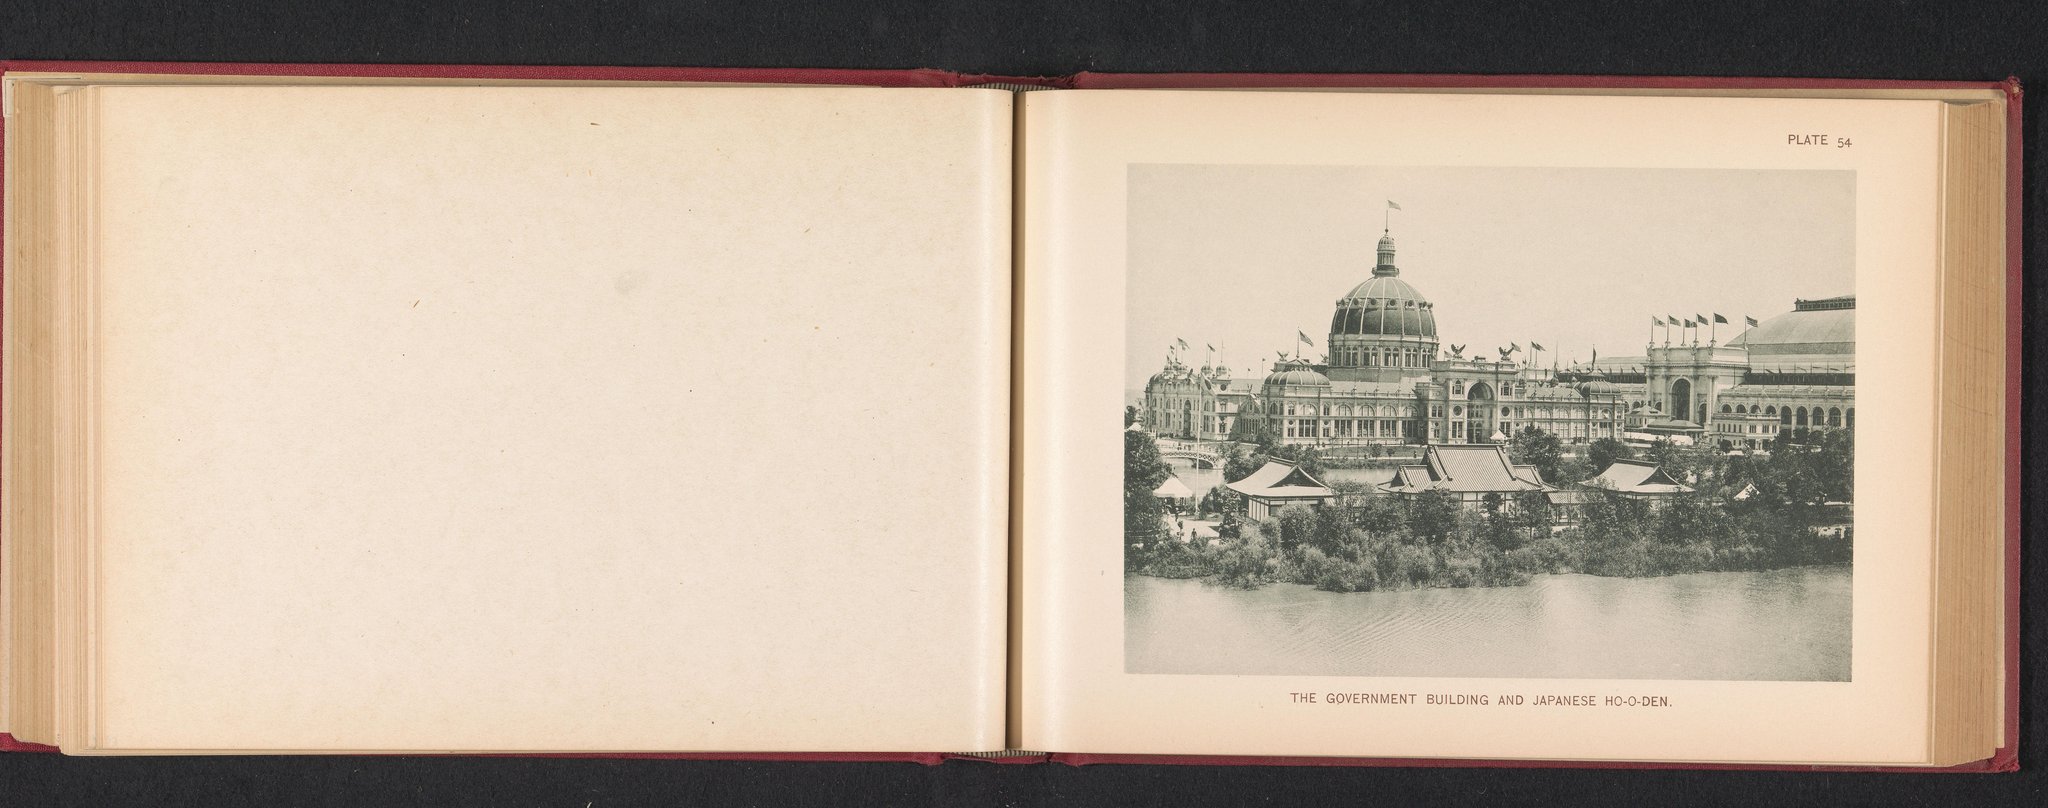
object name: page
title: The Government Building and Japanese Ho-o-den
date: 1893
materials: paper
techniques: photograph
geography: chicago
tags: world fair, world exhibition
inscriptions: number: ‘Plate 54’